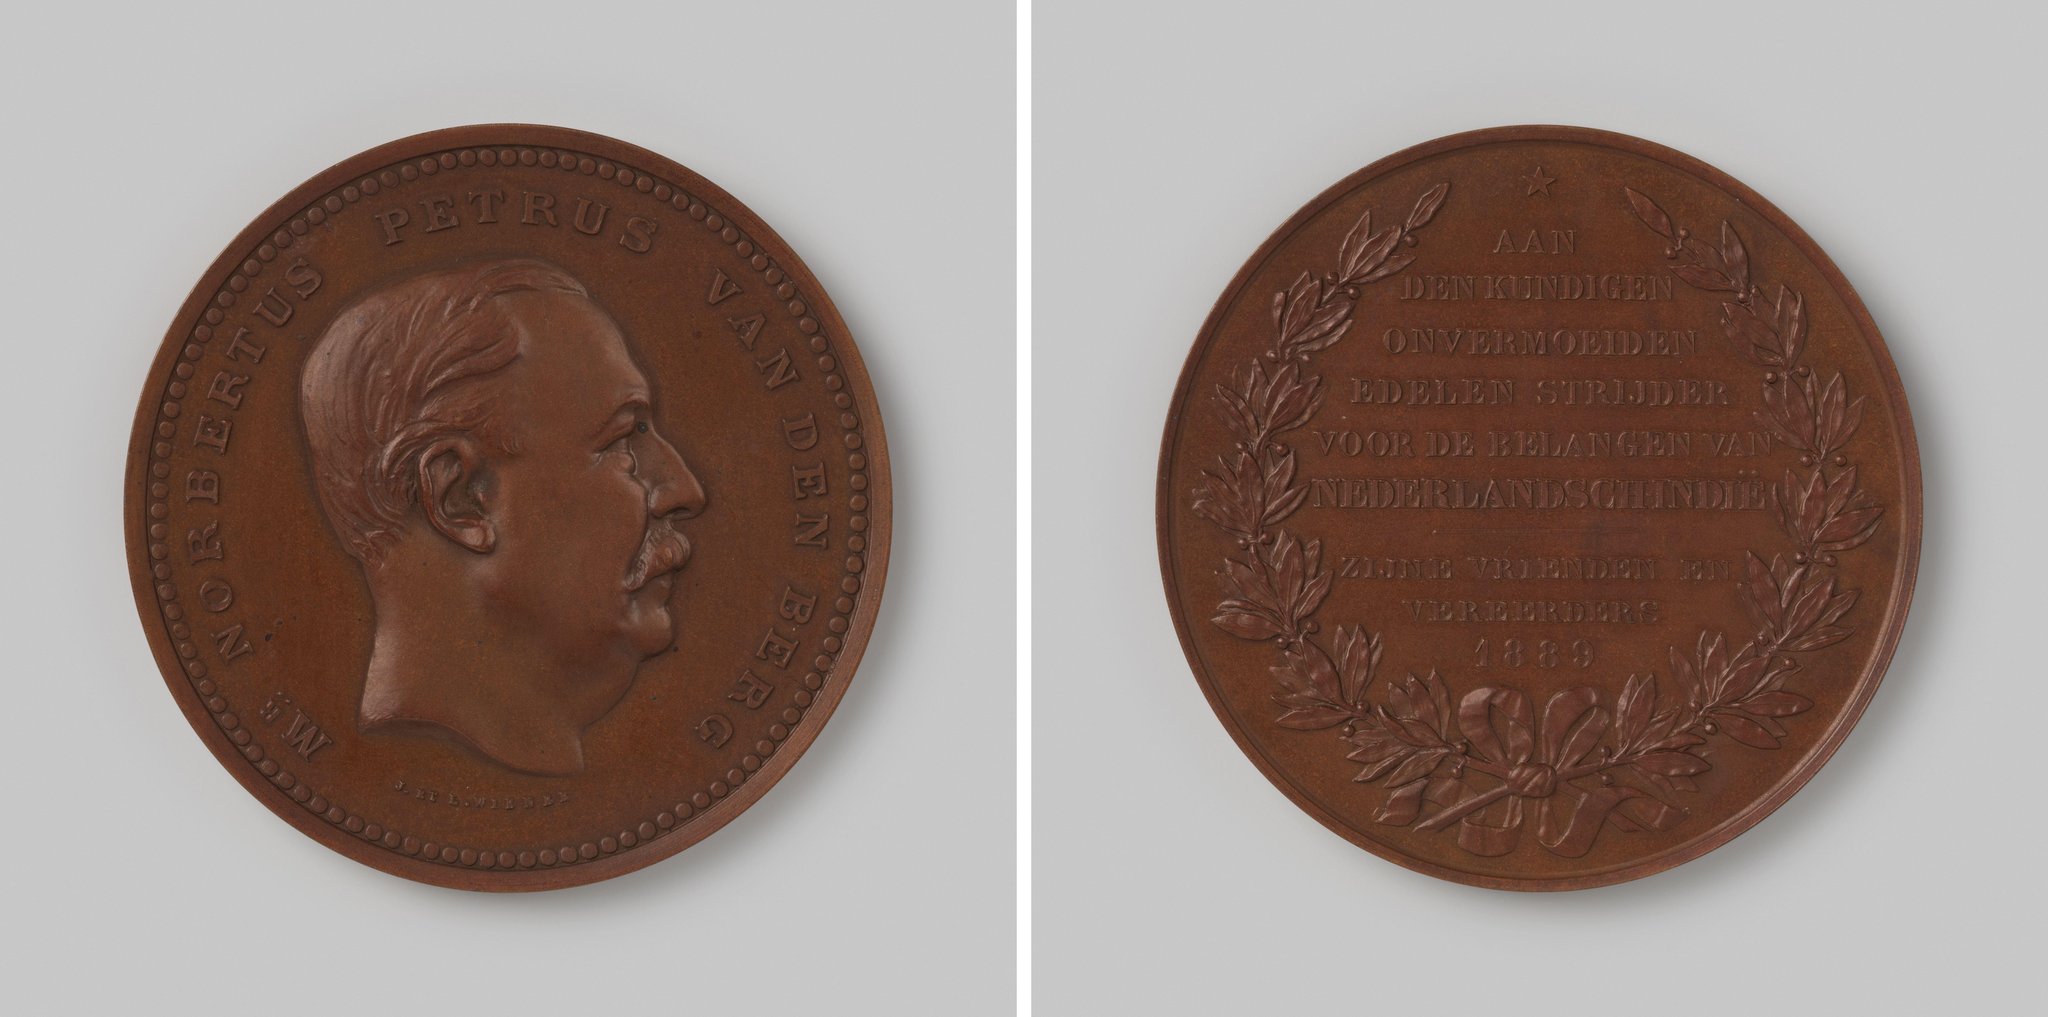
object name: history medal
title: Norbertus Petrus van den Berg president van de Nederlandsche Bank 1889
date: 1889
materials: bronze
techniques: striking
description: Bronzen penning, op de voorzijde het portret van Van den Berg naar rechts met omschrift, op de keerzijde negen regels tekst tussen samengestrikte lauwertakken.